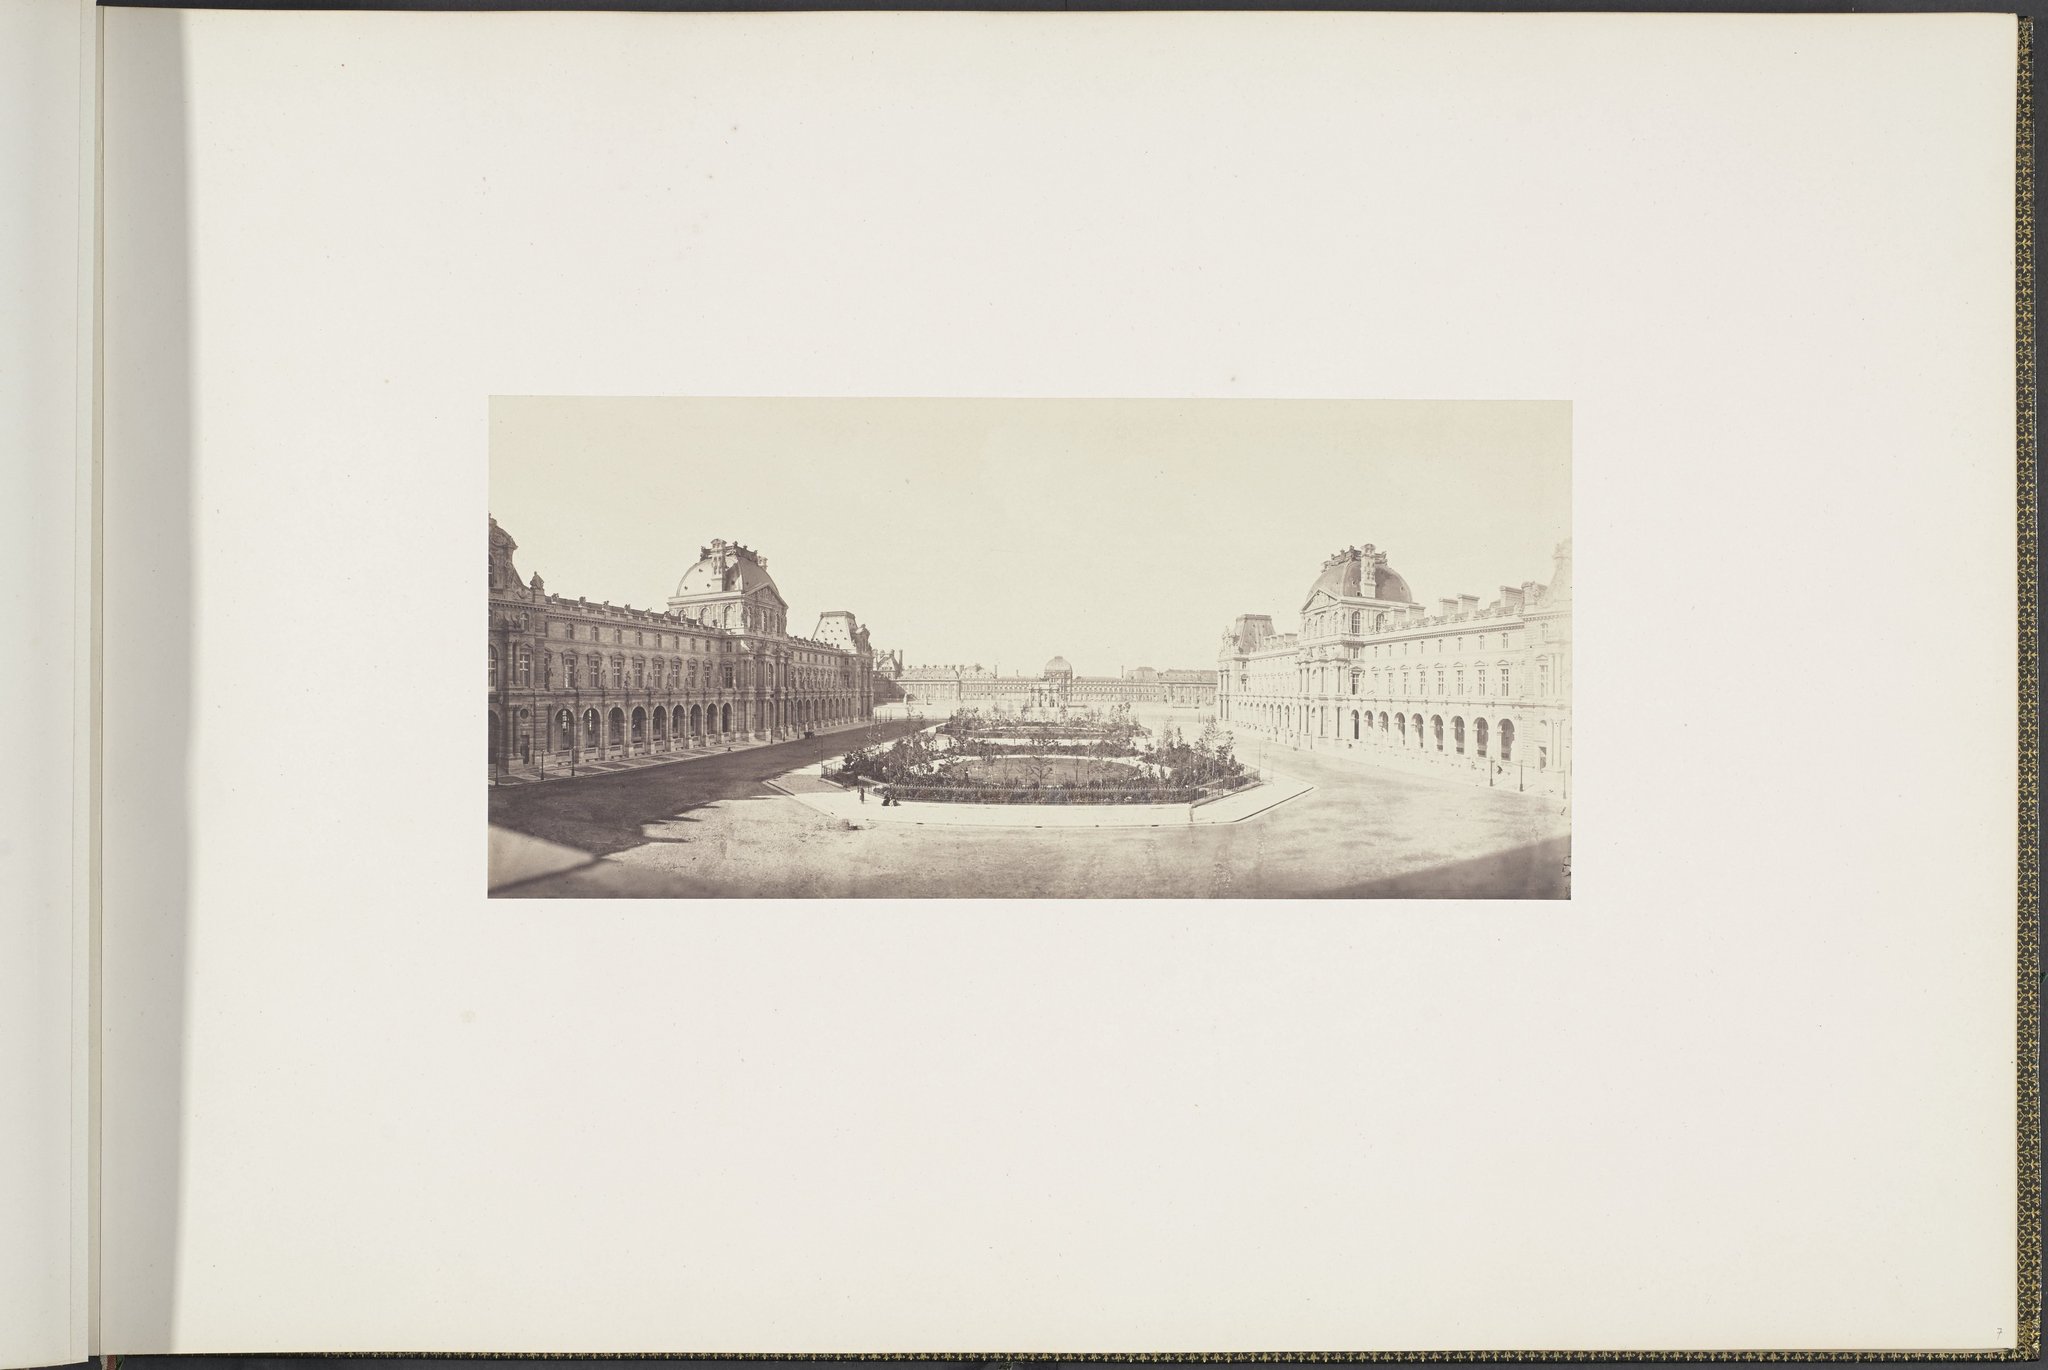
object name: album leaf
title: Panorama van het Nieuwe Louvre: cour Napoléon gezien vanaf de Tuilerieën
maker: édouard denis baldus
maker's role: fotograaf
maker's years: 1813-1889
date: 1857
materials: paper, photographic support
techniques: salted paper print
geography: paris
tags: permanent exhibition, museum, paris, tuileries palace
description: Onderdeel van Réunion des Tuileries au Louvre 1852-1857, album 1.